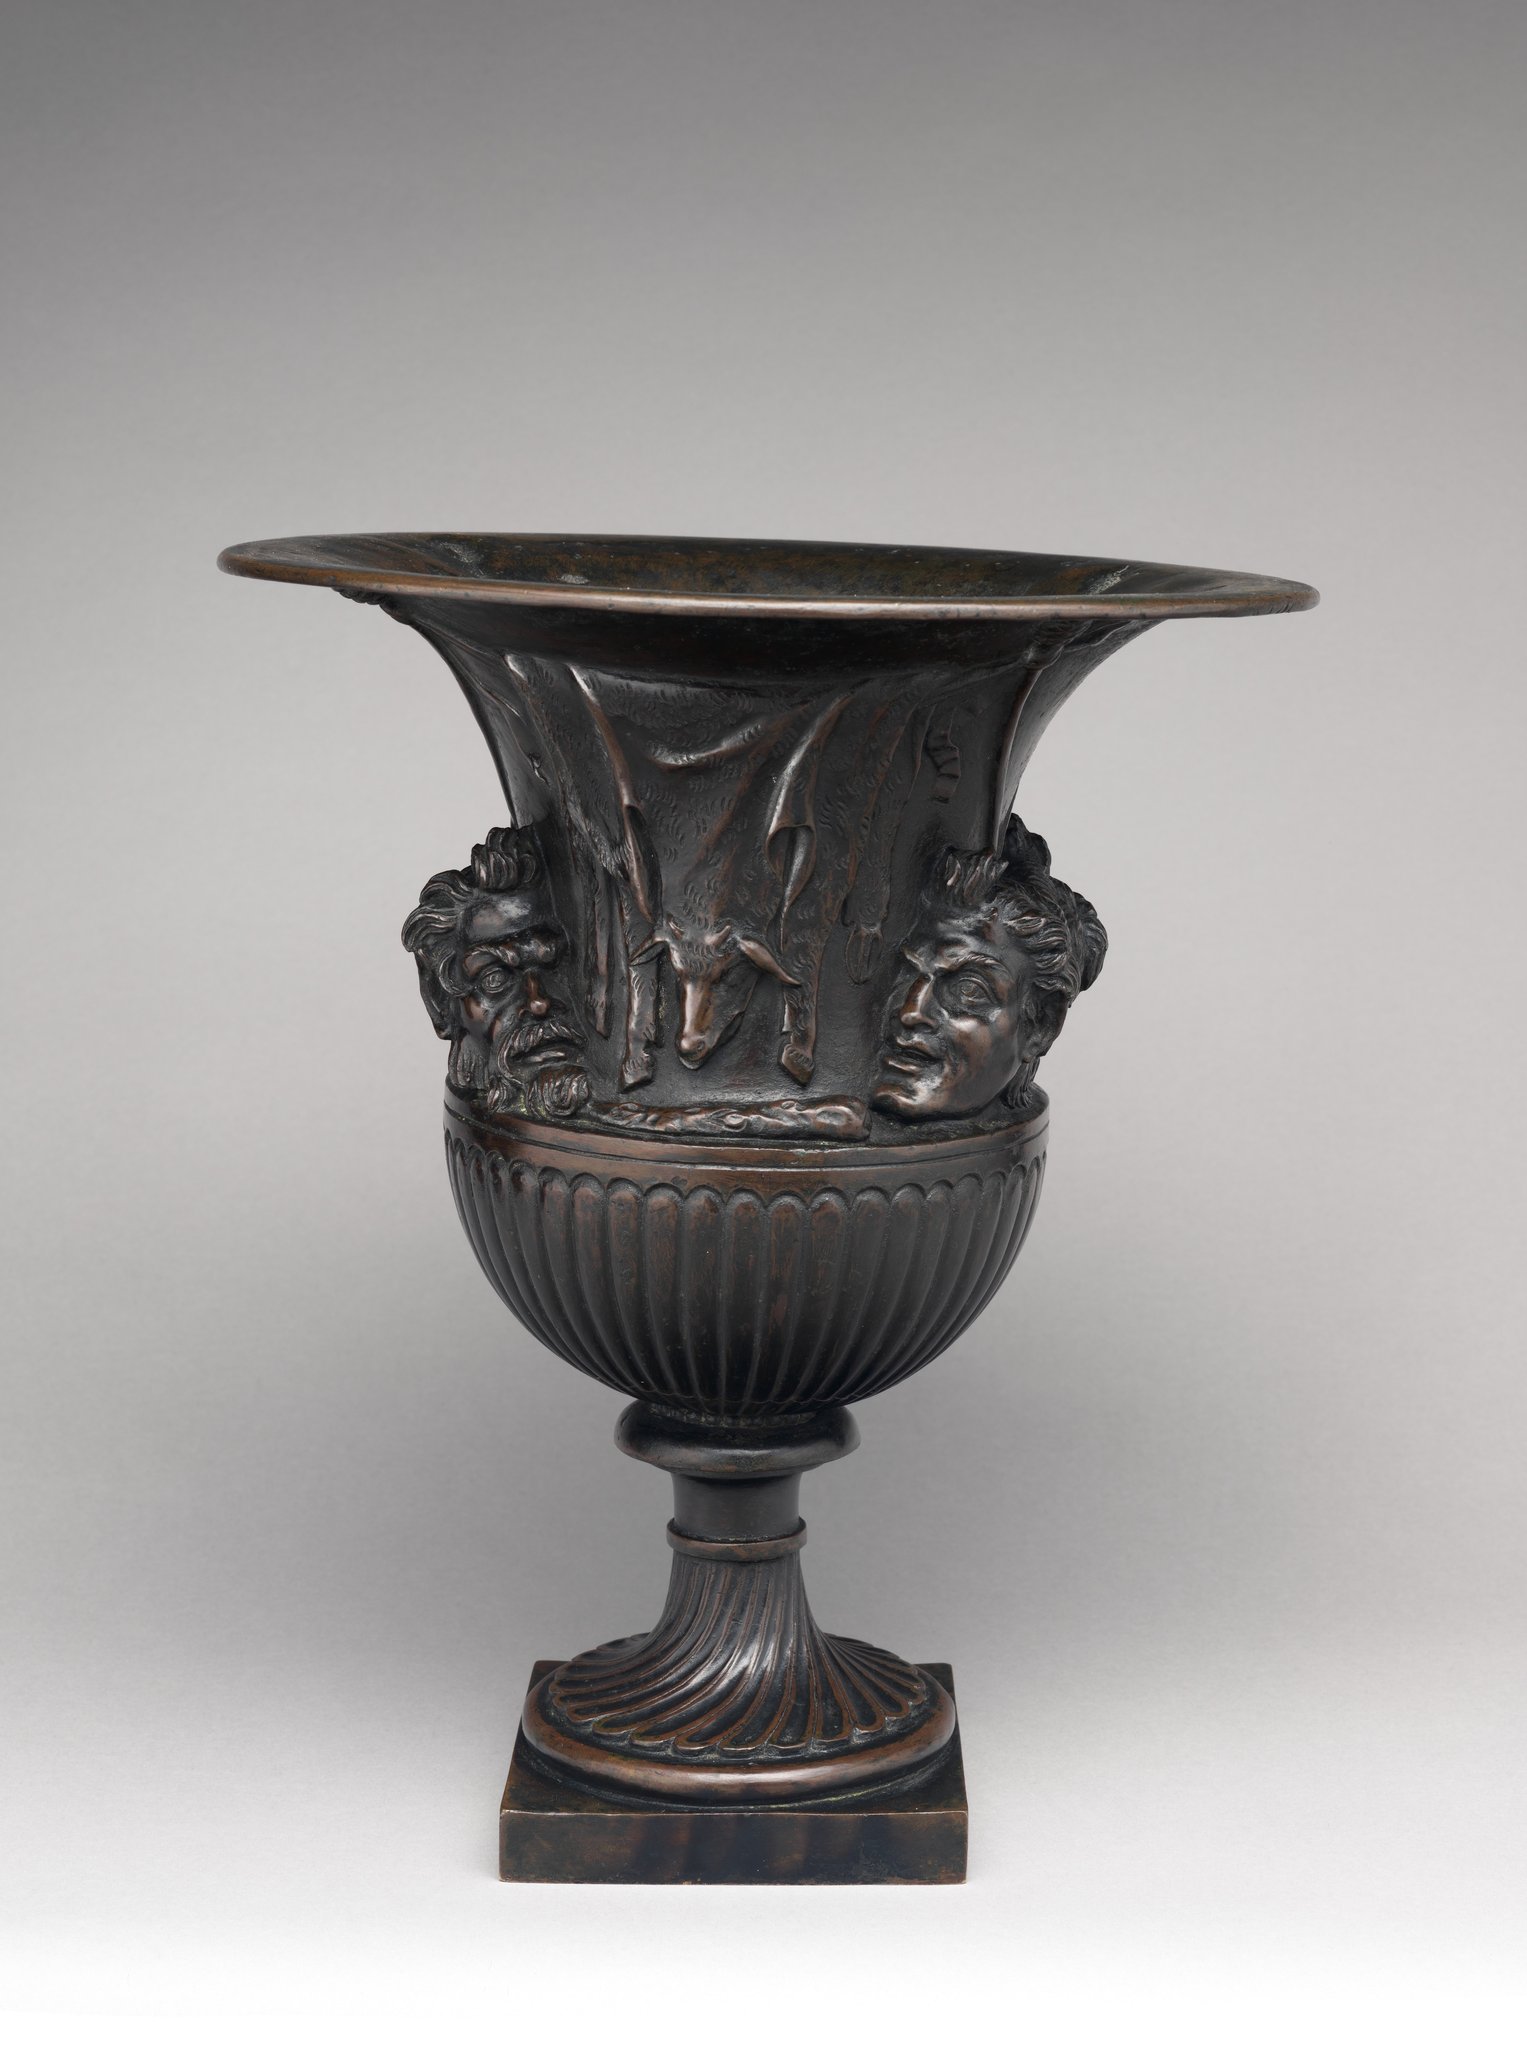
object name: vase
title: Borghese vase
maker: giovanni zoffoli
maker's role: maker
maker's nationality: italian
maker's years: 1745-1805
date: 1795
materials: bronze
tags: masks,faces,goats